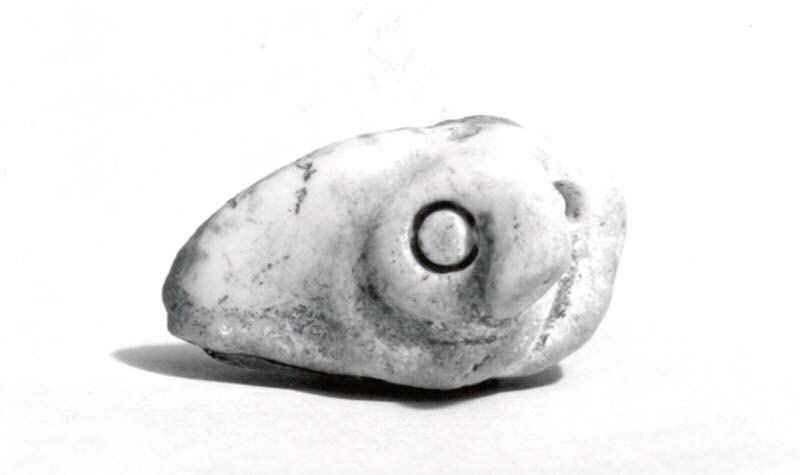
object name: necklace, bead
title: Amulet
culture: iranian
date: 3000-2001 BCE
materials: stone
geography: iran